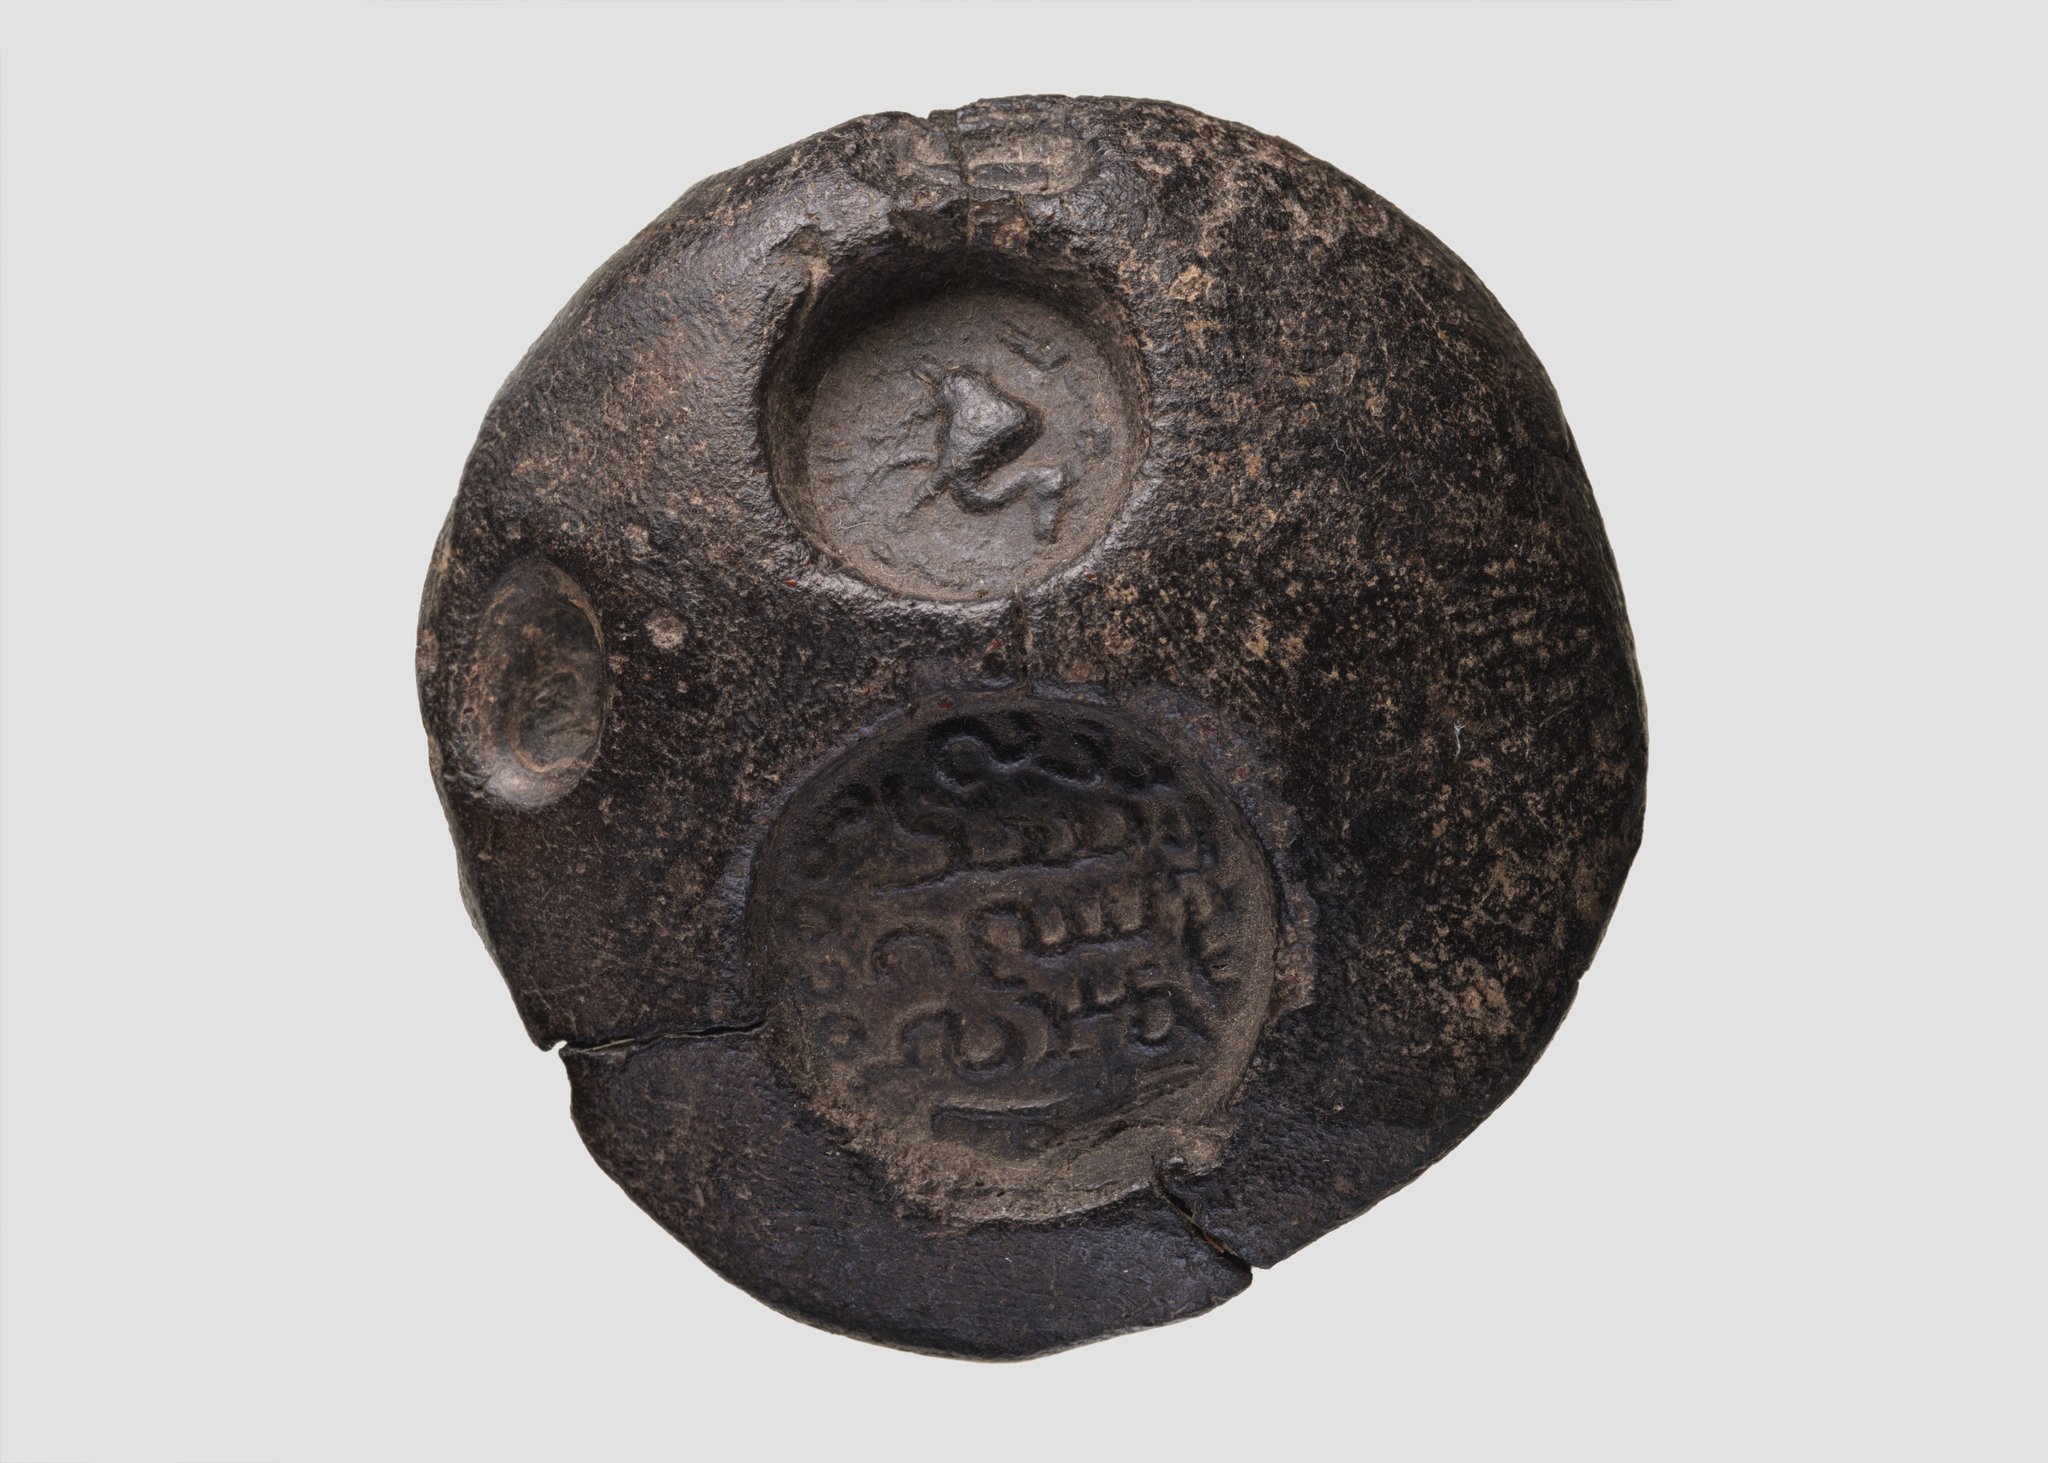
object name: sealing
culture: sasanian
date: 601-700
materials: clay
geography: iran